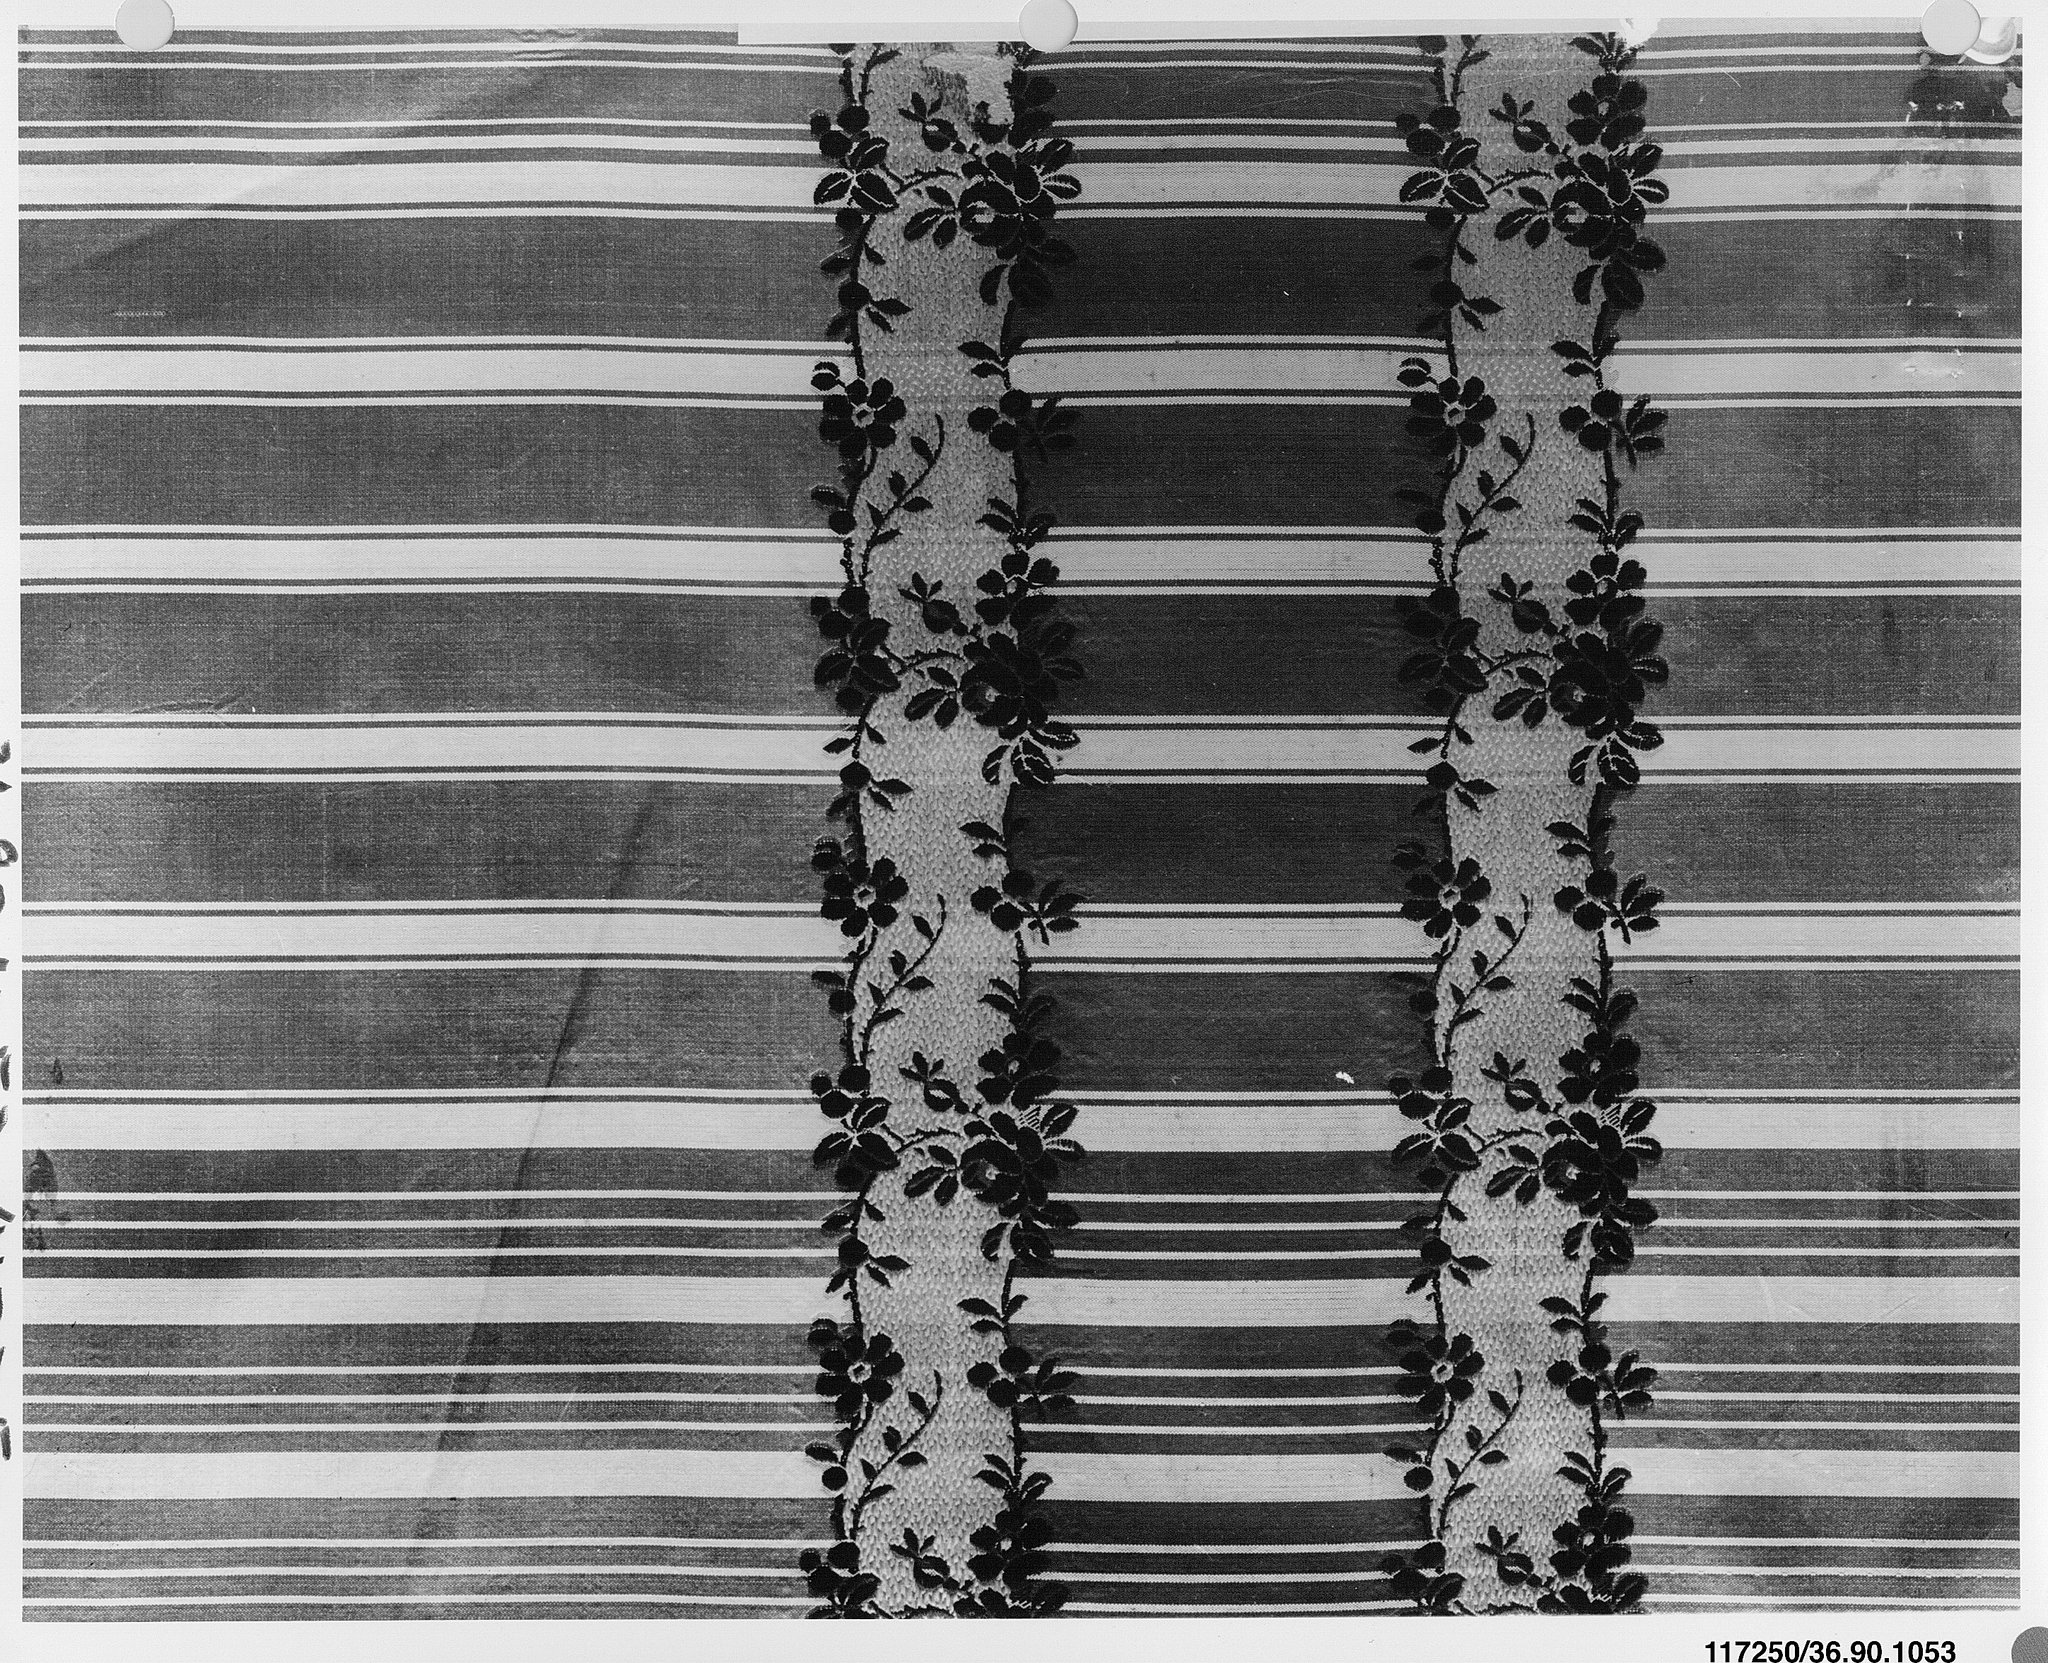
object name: piece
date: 1801-1900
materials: silk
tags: flowers,leaves